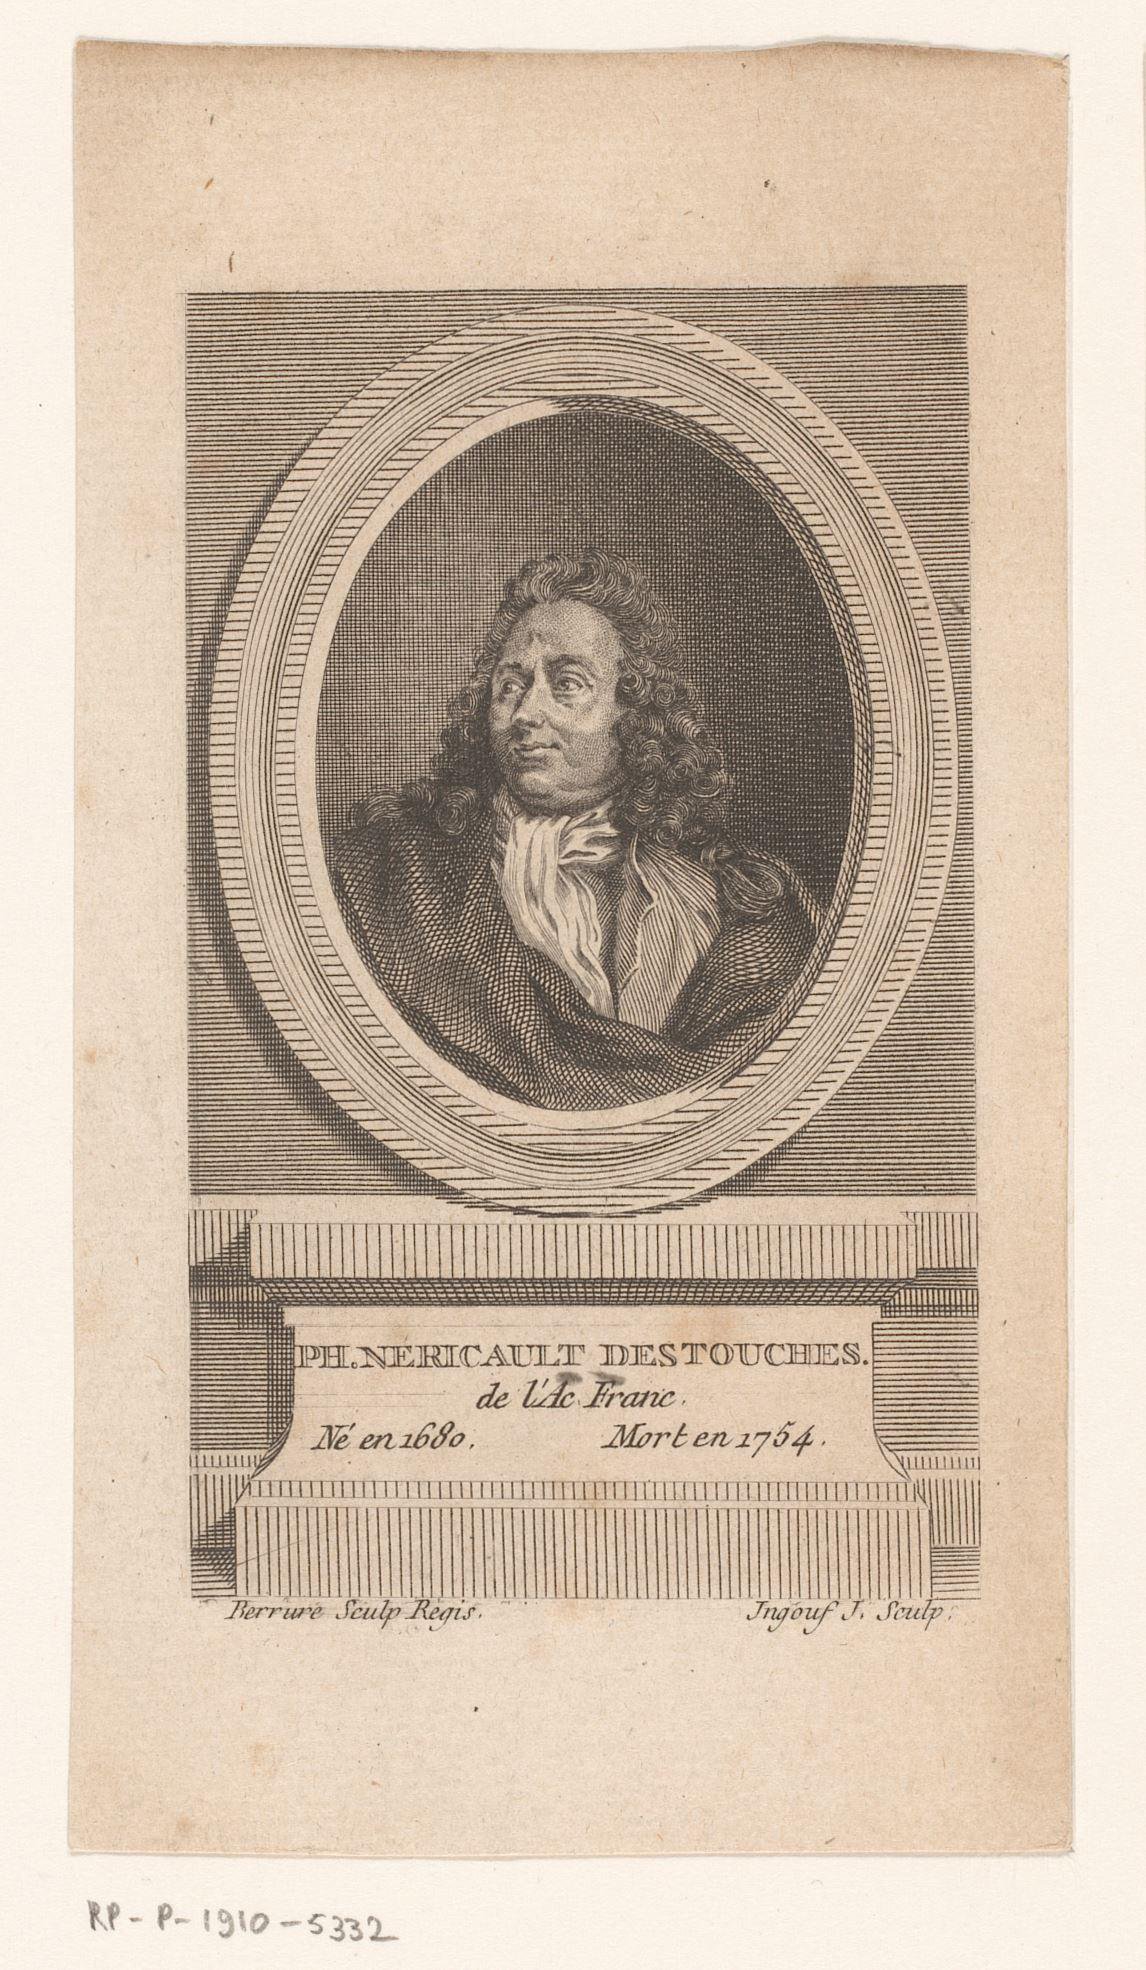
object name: print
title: Portret van Philippe Néricault Destouches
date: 1778-1787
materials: paper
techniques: engraving, etching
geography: paris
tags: philippe néricault destouches, historical persons, portrait of actor, actress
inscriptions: collector's mark: Lugt 2228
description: Prent uit: Annales poétiques, ou Almanach des Muses. Parijs: Delalain, 1778-1787, dl. 36.